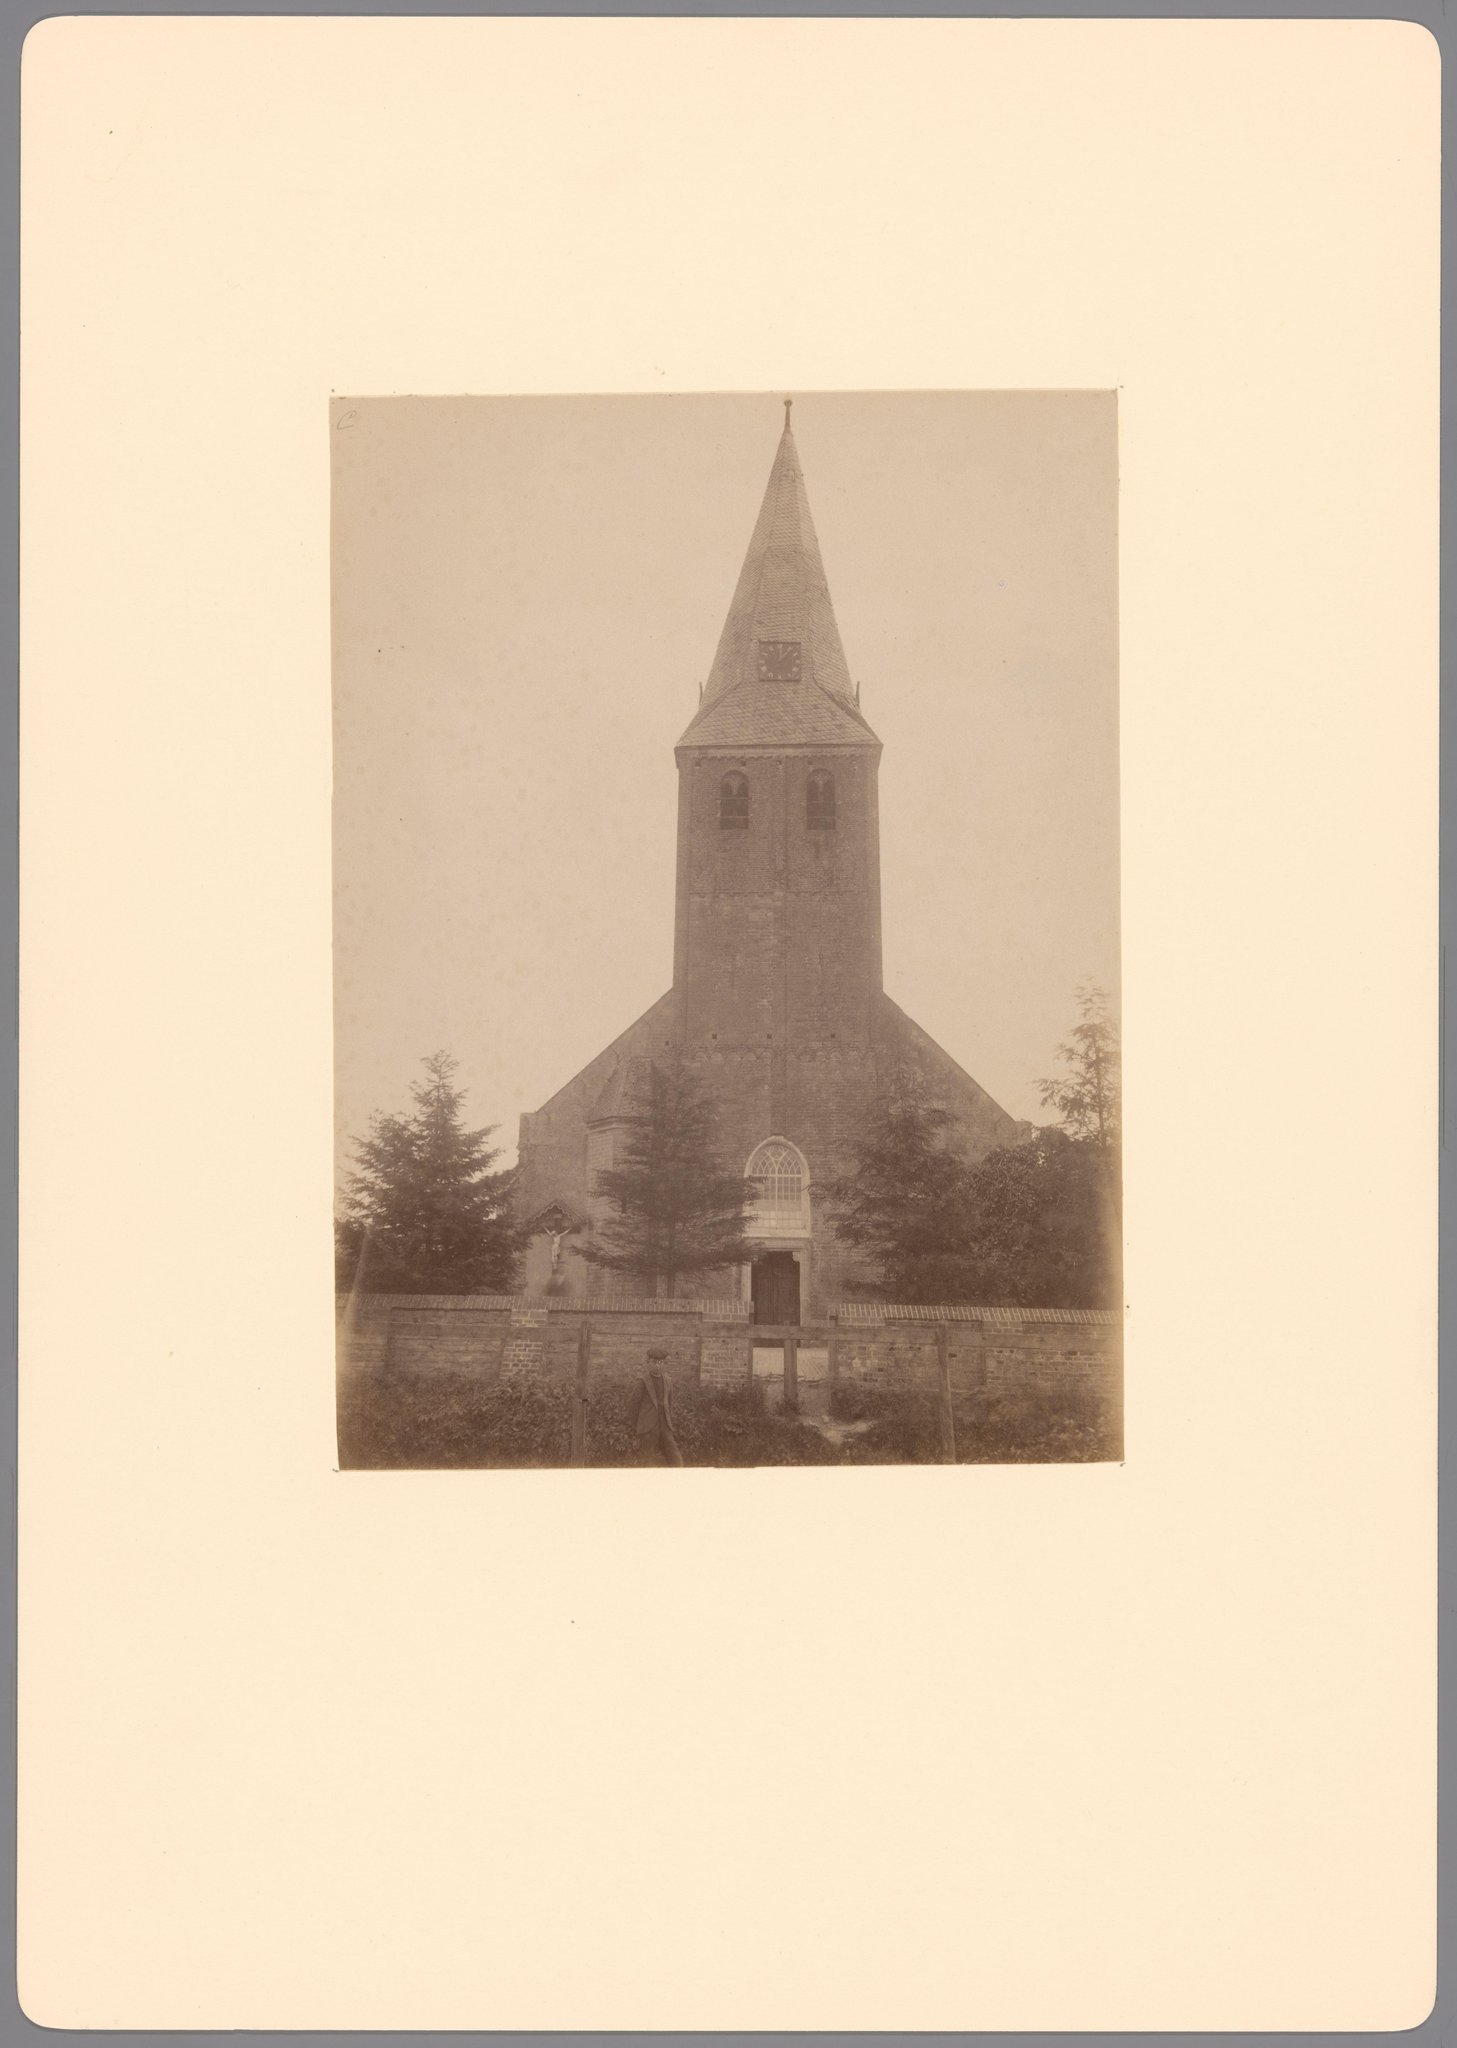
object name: photograph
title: Toren van de Remigiuskerk te Duiven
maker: anoniem (monumentenzorg)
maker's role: fotograaf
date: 1905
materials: cardboard, photographic support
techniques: albumen print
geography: duiven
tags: parts of church exterior and annexes: tower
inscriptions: annotation: ‘c’, annotation: ‘Duiven R.K. Kerk’